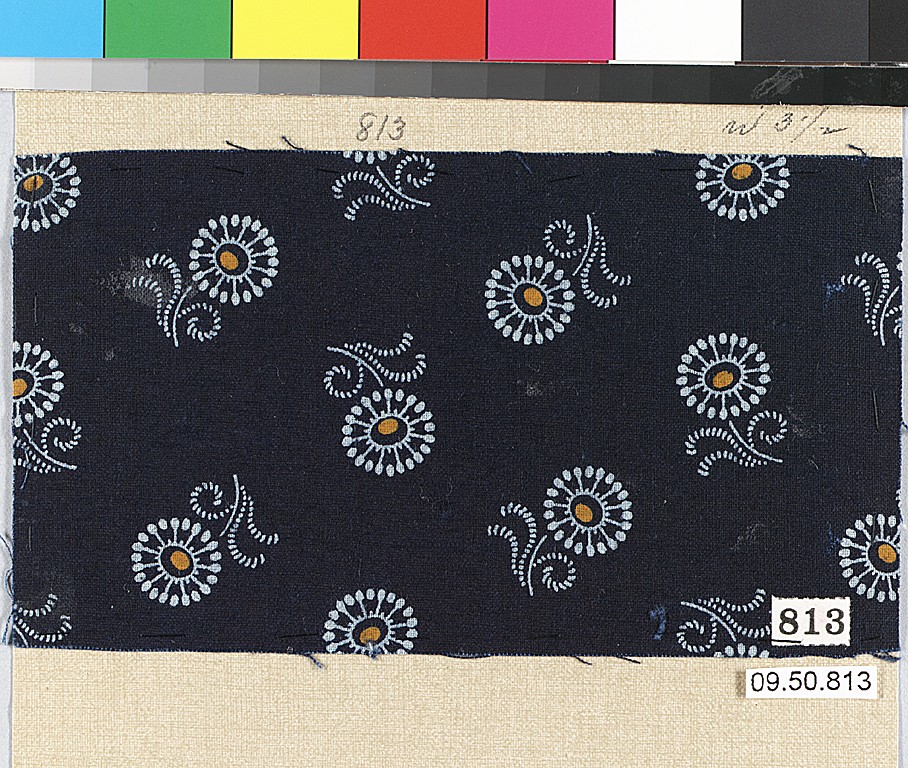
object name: piece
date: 1801-1900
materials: cotton